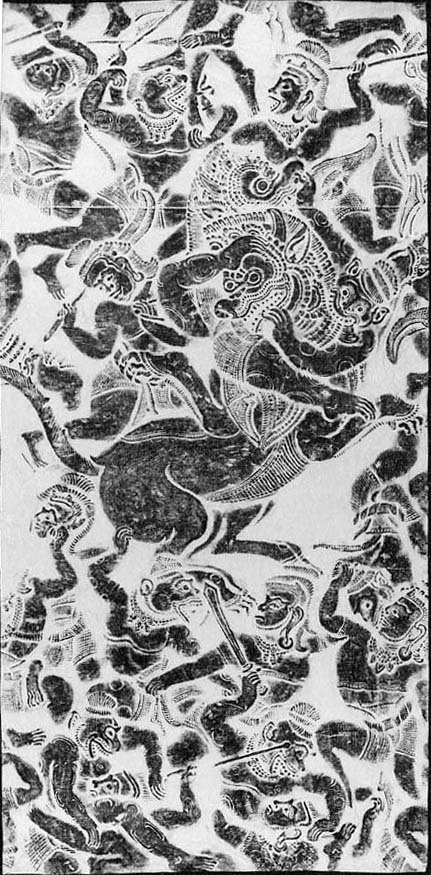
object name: rubbing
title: Rubbings of a Scene from the Ramayana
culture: cambodian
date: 1901-2000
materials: ink, paper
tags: soldiers,weapons,horses,hinduism